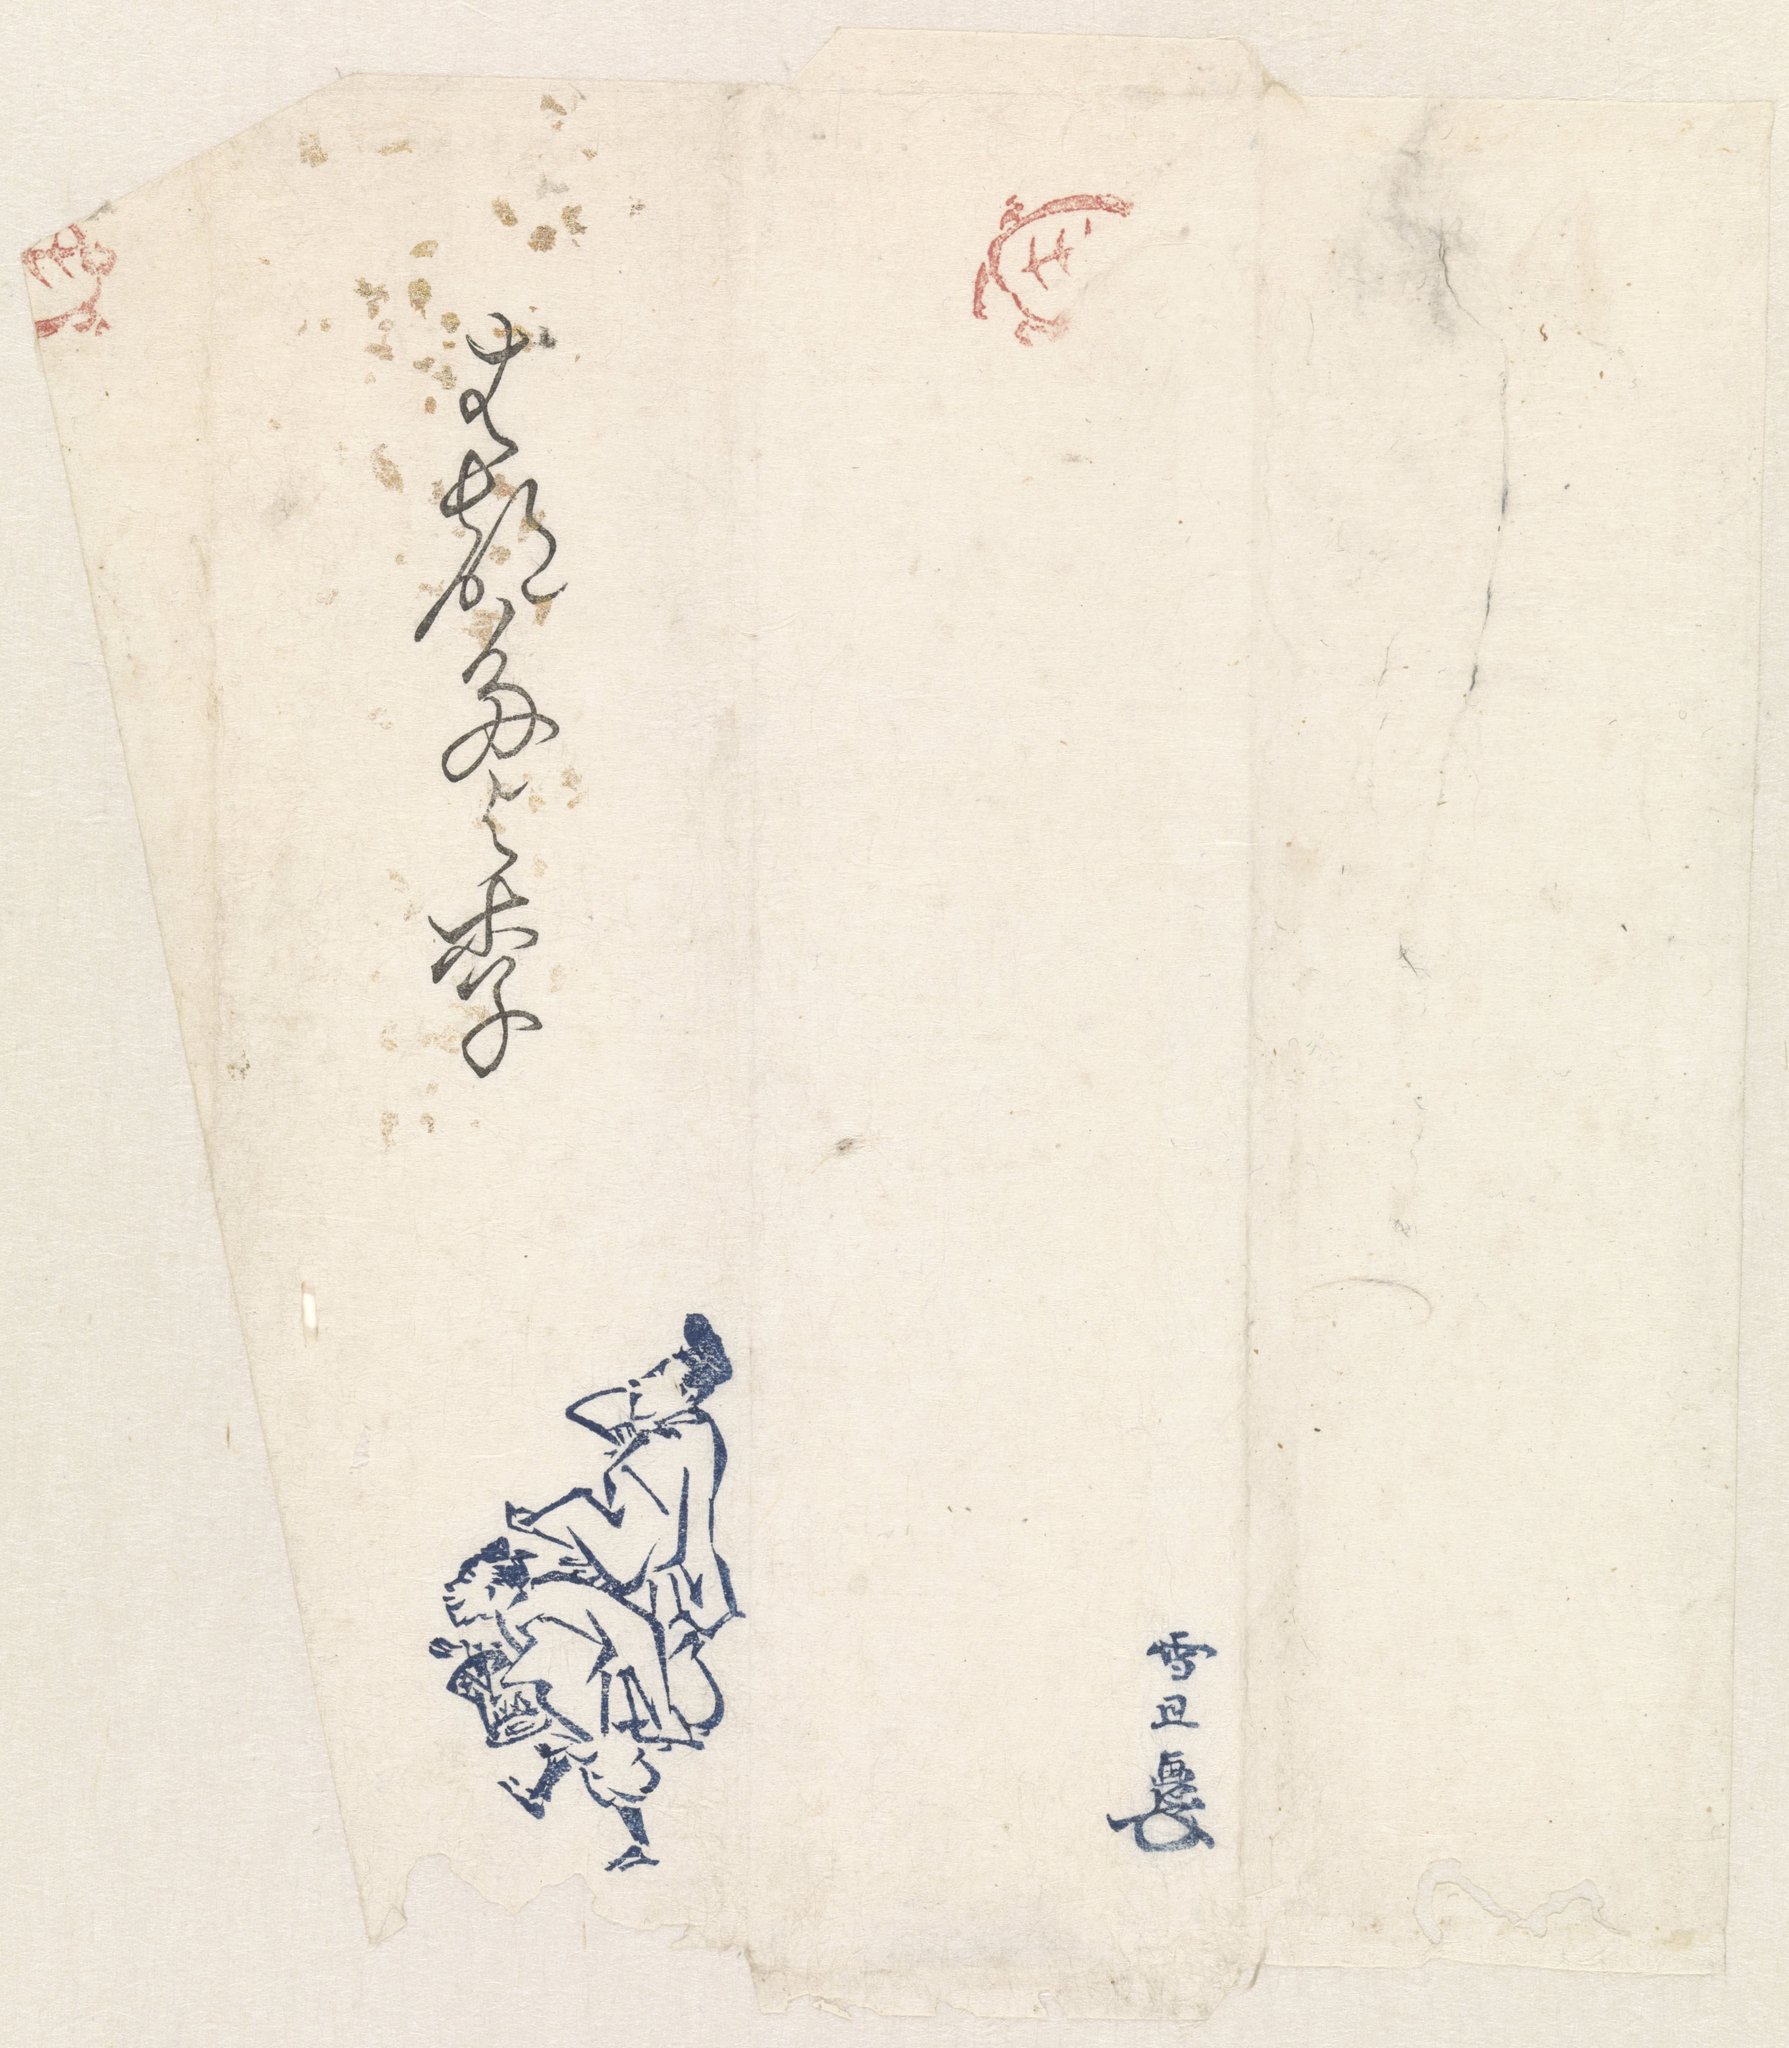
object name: surimono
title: Envelop met twee manzai-dansers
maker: hasegawa settan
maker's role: print maker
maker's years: 1778-1843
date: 1800-1850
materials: paper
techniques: woodcut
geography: japan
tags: adult man (+ two persons), dancing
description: Een surimono is een luxe uitgevoerde prent waarop beeld met één of meerdere gedichten gecombineerd is. Bij het drukken van een surimono werd vaak gebruik gemaakt van dikker papier, blinddruk en metaal pigmenten, zoals koper- en zilverpoeder. De prenten werden vaak in opdracht van dichters gemaakt en als exclusief geschenk aan vrienden en relaties gegeven.